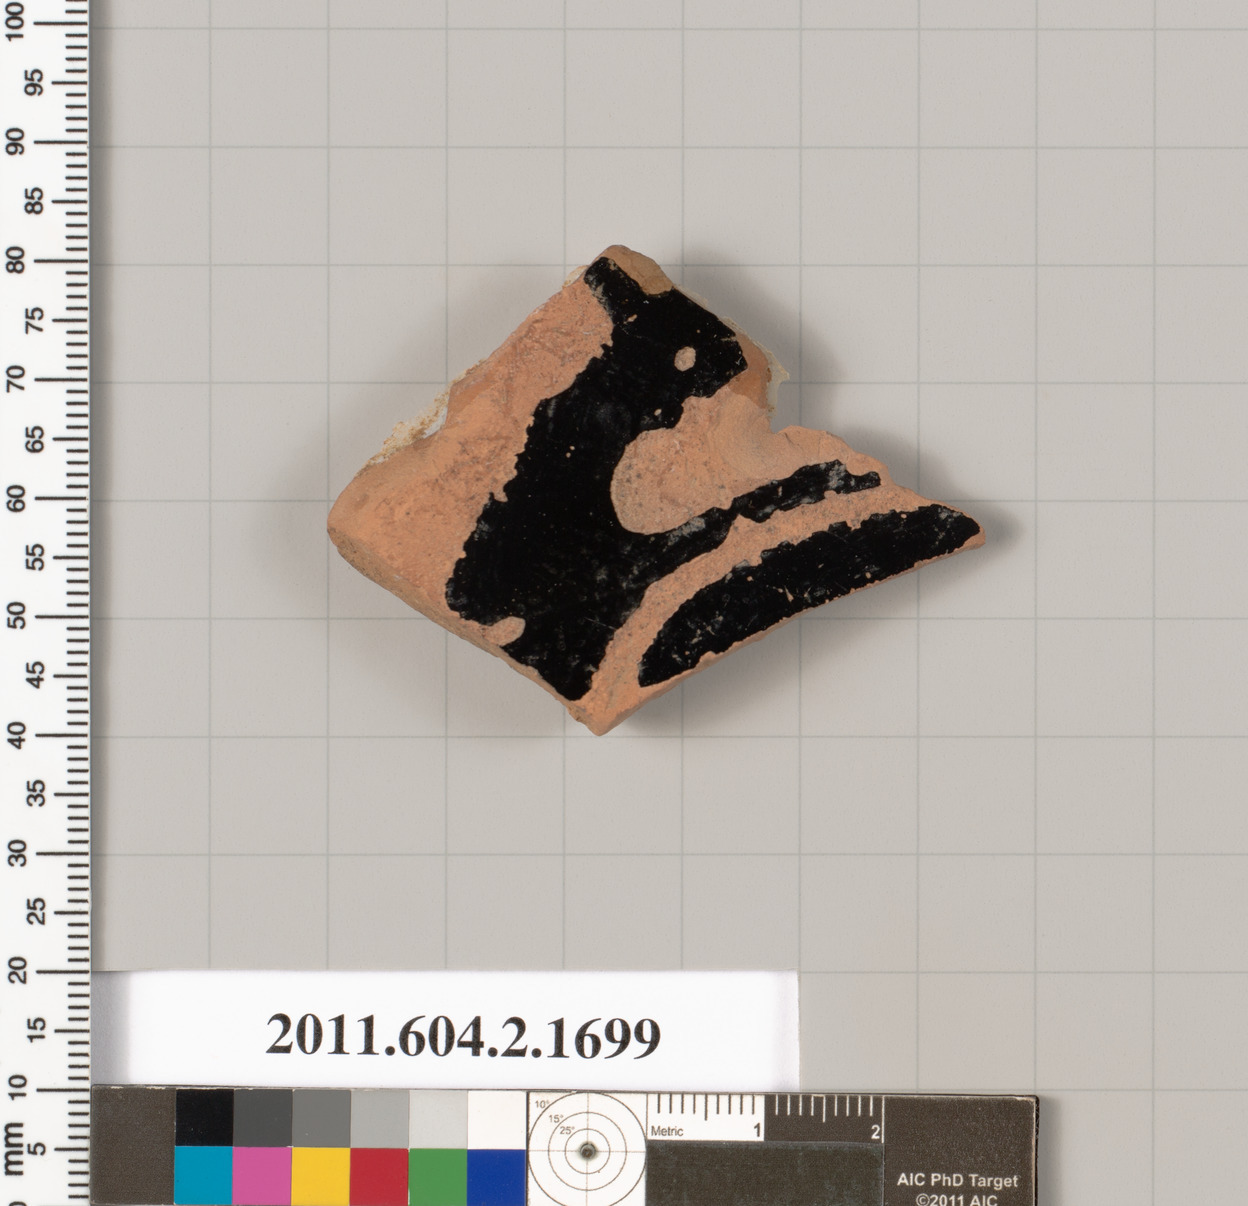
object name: skyphos fragment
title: Terracotta fragment of a skyphos (deep drinking cup)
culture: greek, attic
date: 500-401 BCE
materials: terracotta